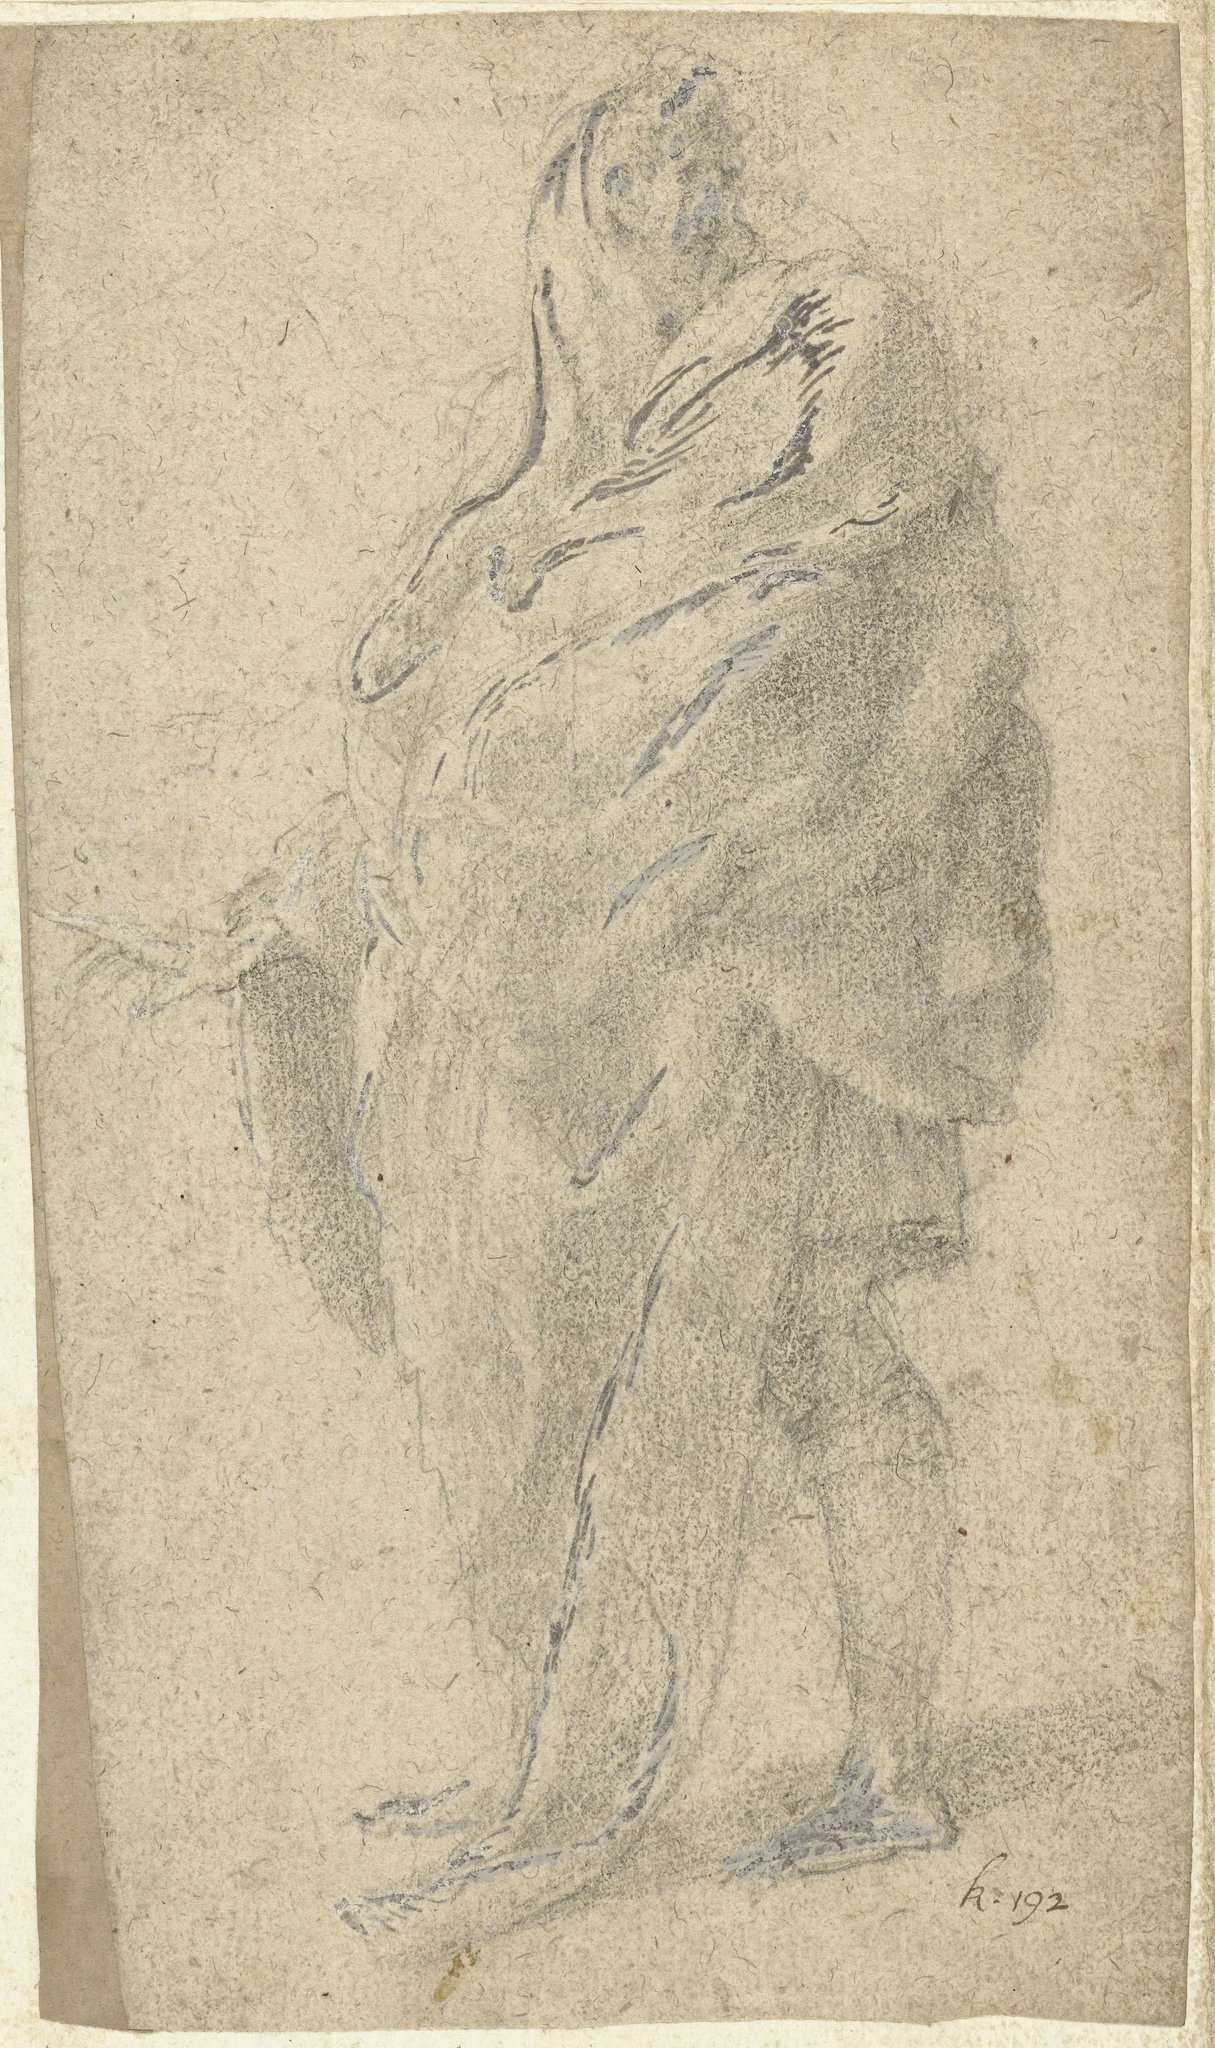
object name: drawing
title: Gedrapeerde figuur, schrijnend naar links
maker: polidoro da caravaggio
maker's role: draughtsman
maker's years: 1490-1543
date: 1502-1543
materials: paper, pencil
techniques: brush